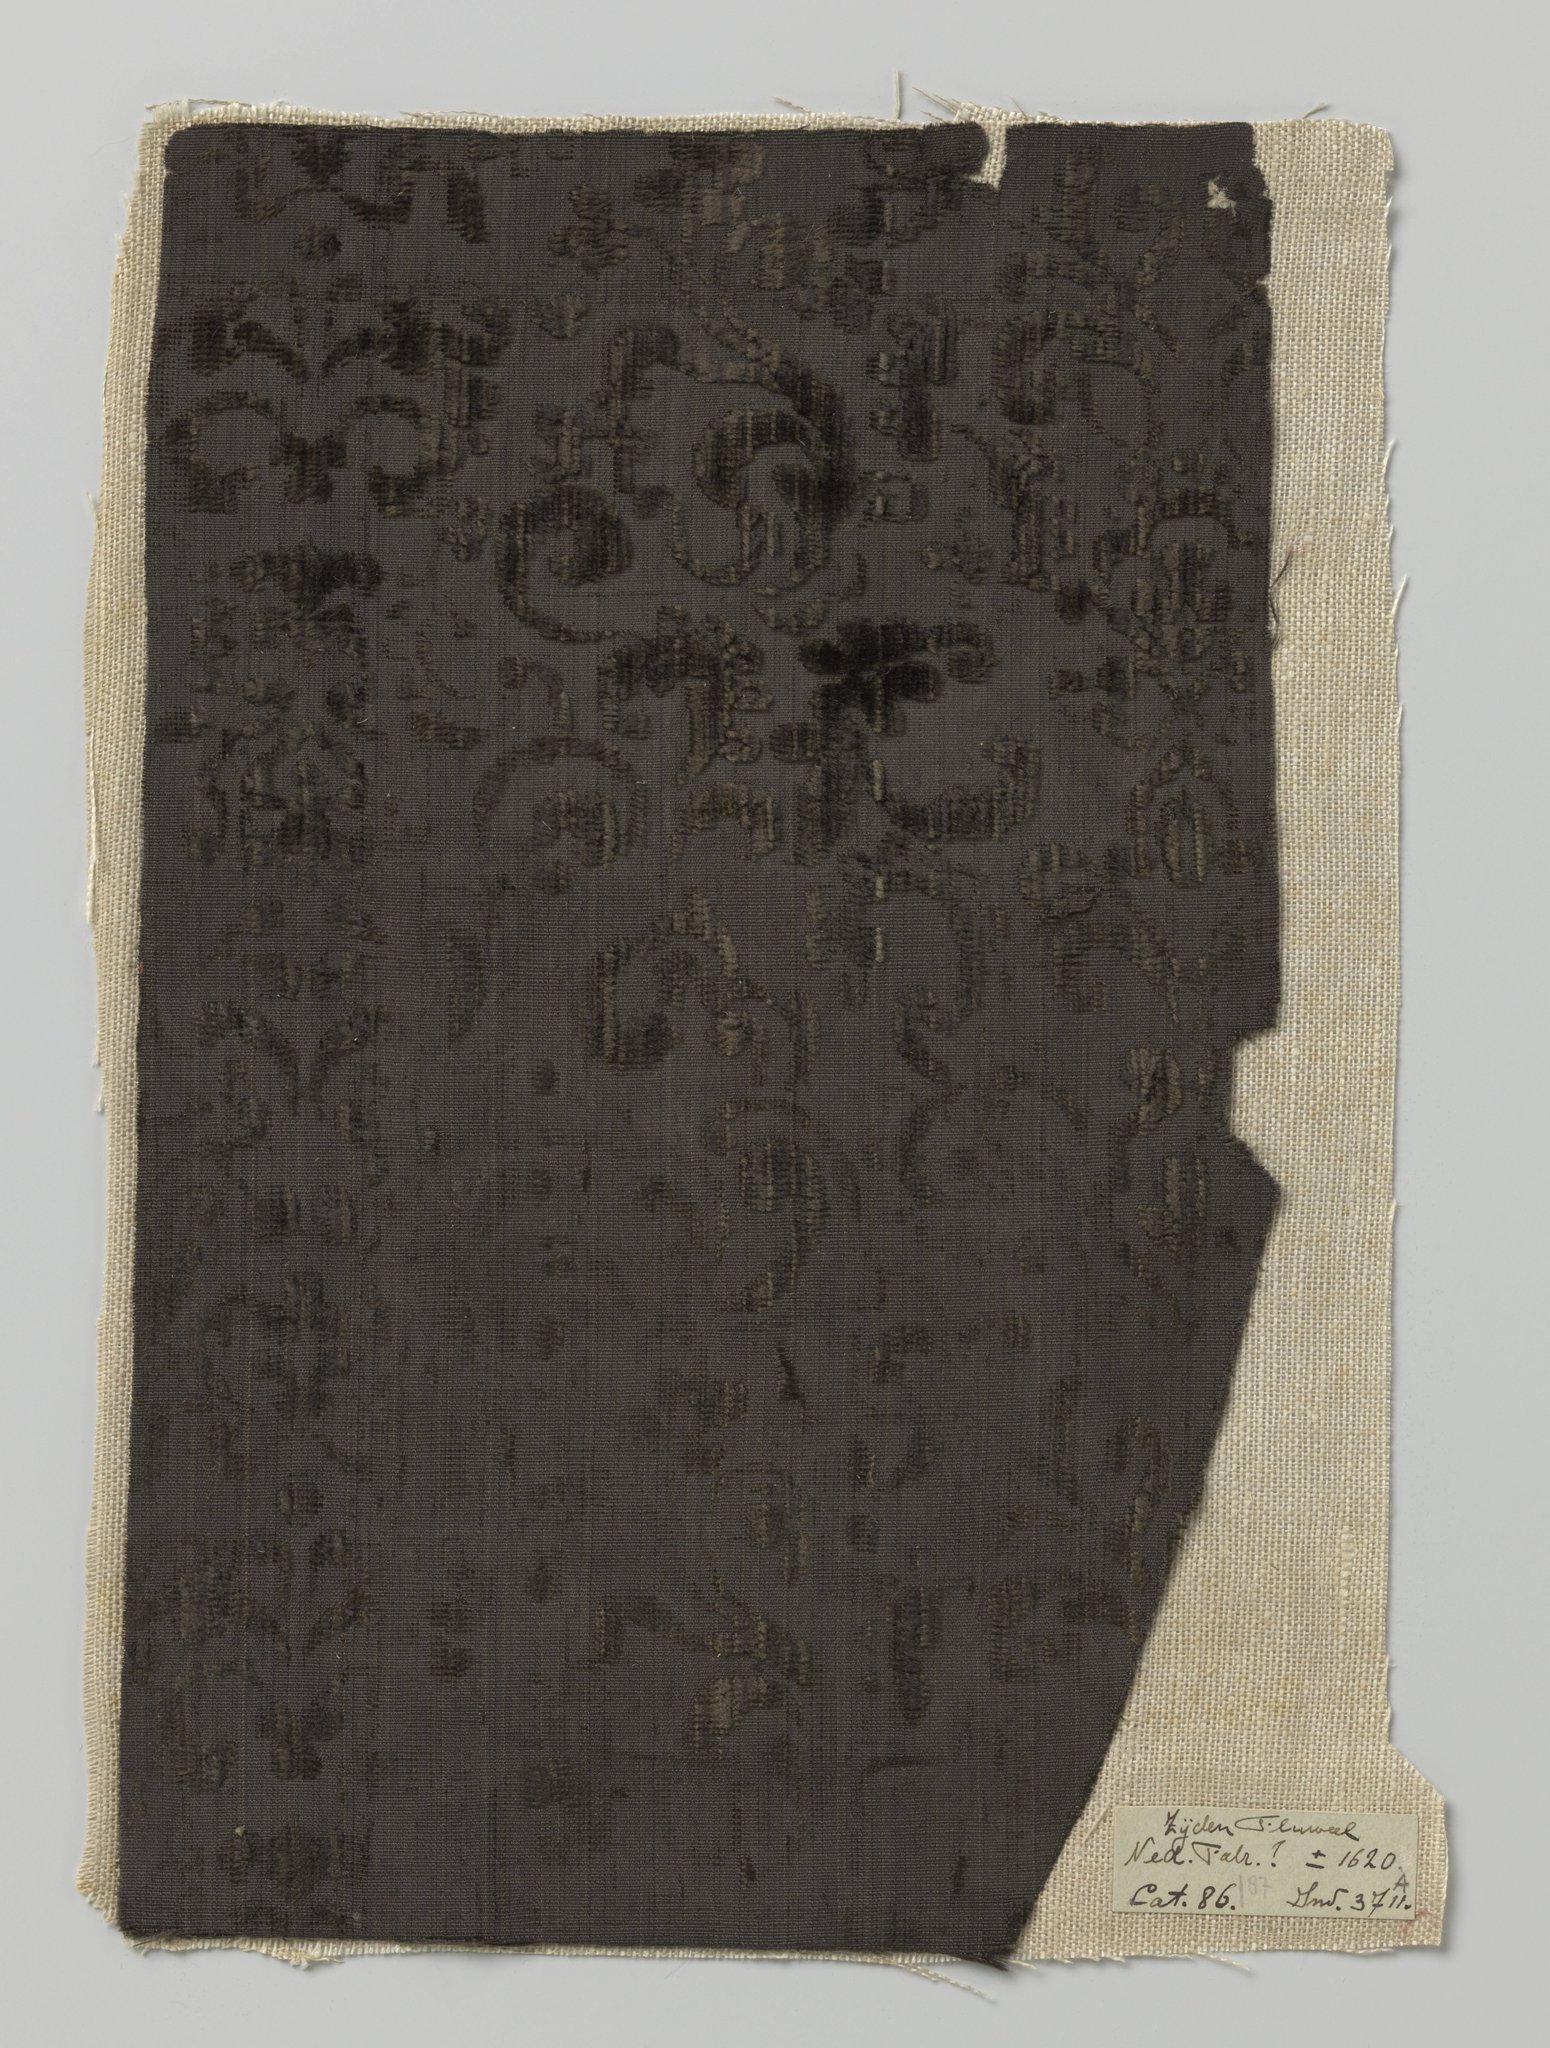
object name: fragment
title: Fragment zijde reliëffluweel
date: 1600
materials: silk, velvet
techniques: weave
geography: netherlands